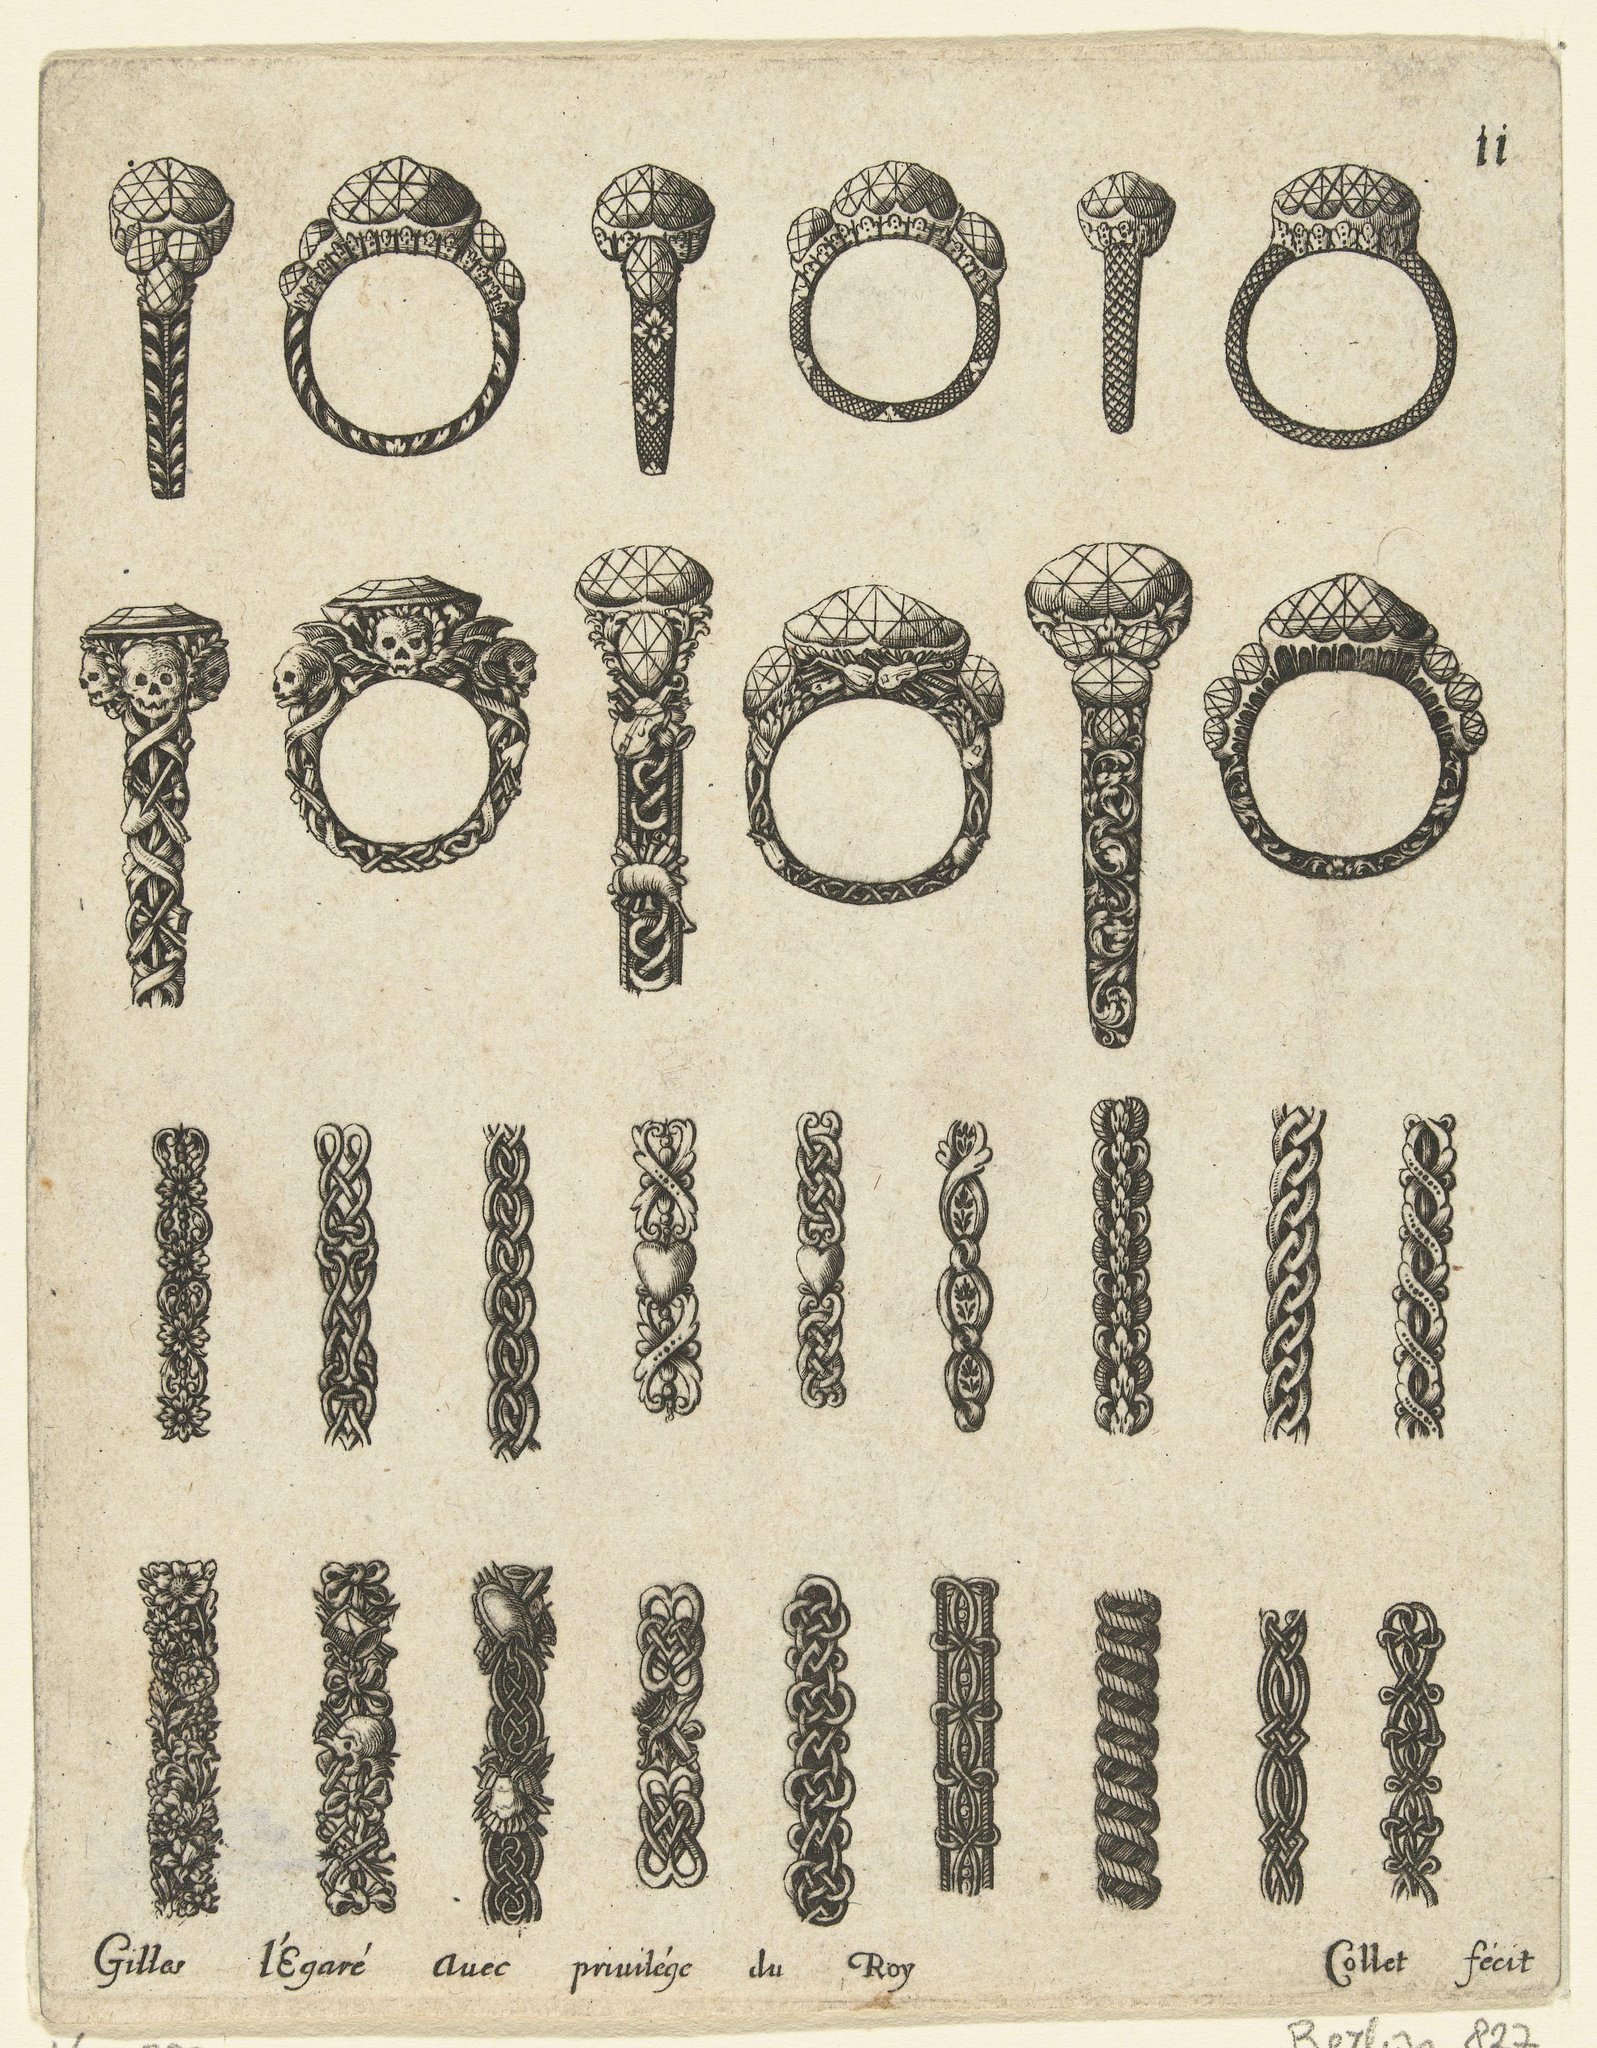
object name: print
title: Ontwerpen voor juwelen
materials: paper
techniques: engraving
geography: paris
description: Vier rijen, twee met drie ringen afgebeeld van voren en opzij en twee met negen ontwerpen voor ringschouders. Prent is genummerd: ii. Blad 5 uit tweede serie met ontwerpen voor juwelen bestaande uit 6 bladen. Tweede druk.